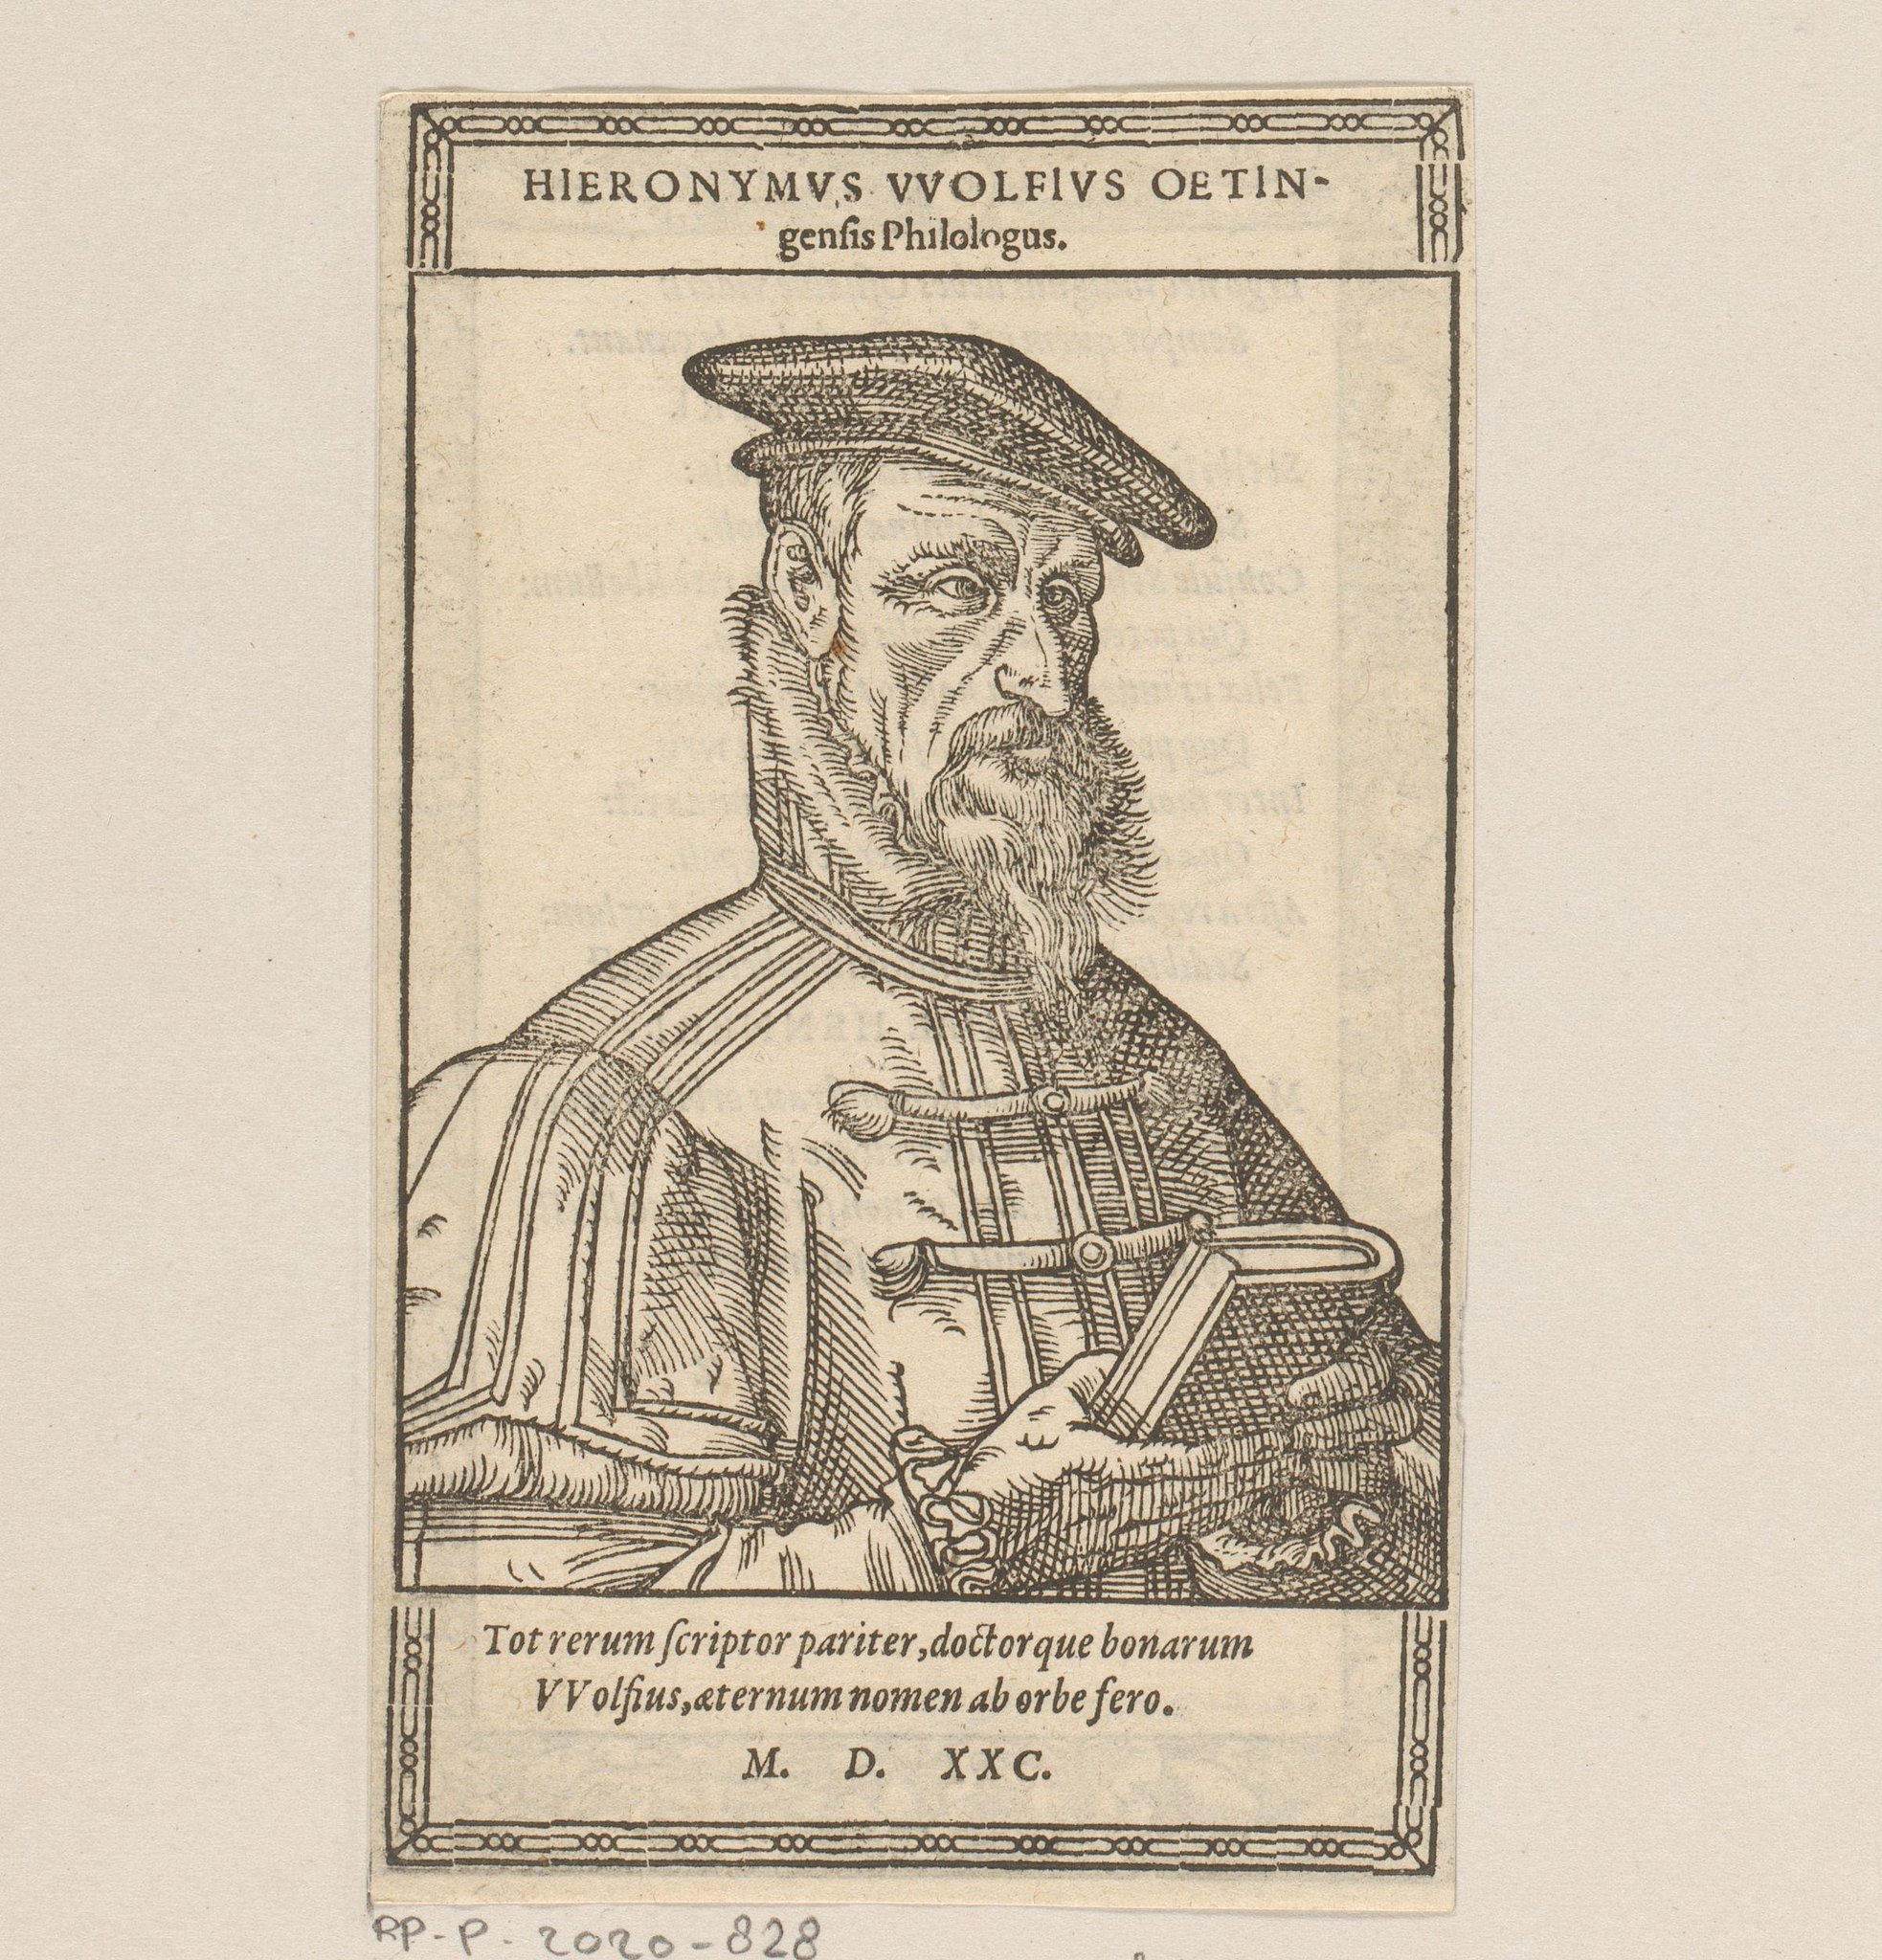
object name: print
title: Portret van Hieronymus Wolf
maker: bernhard jobin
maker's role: printer, publisher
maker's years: 1545-1593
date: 1587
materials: paper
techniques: letterpress printing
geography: straatsburg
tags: scholar, philosopher, historical persons, book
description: Prent uit: Reusner, Nikolaus. Icones sive imagines virorum literis illustrium (...). Straatsburg: Bernhard Jobin, 1587. Prent ook gebruikt in de Duitse editie, uitgegeven in hetzelfde jaar, en de 1590-editie. Prent ook gebruikt in latere publicaties.